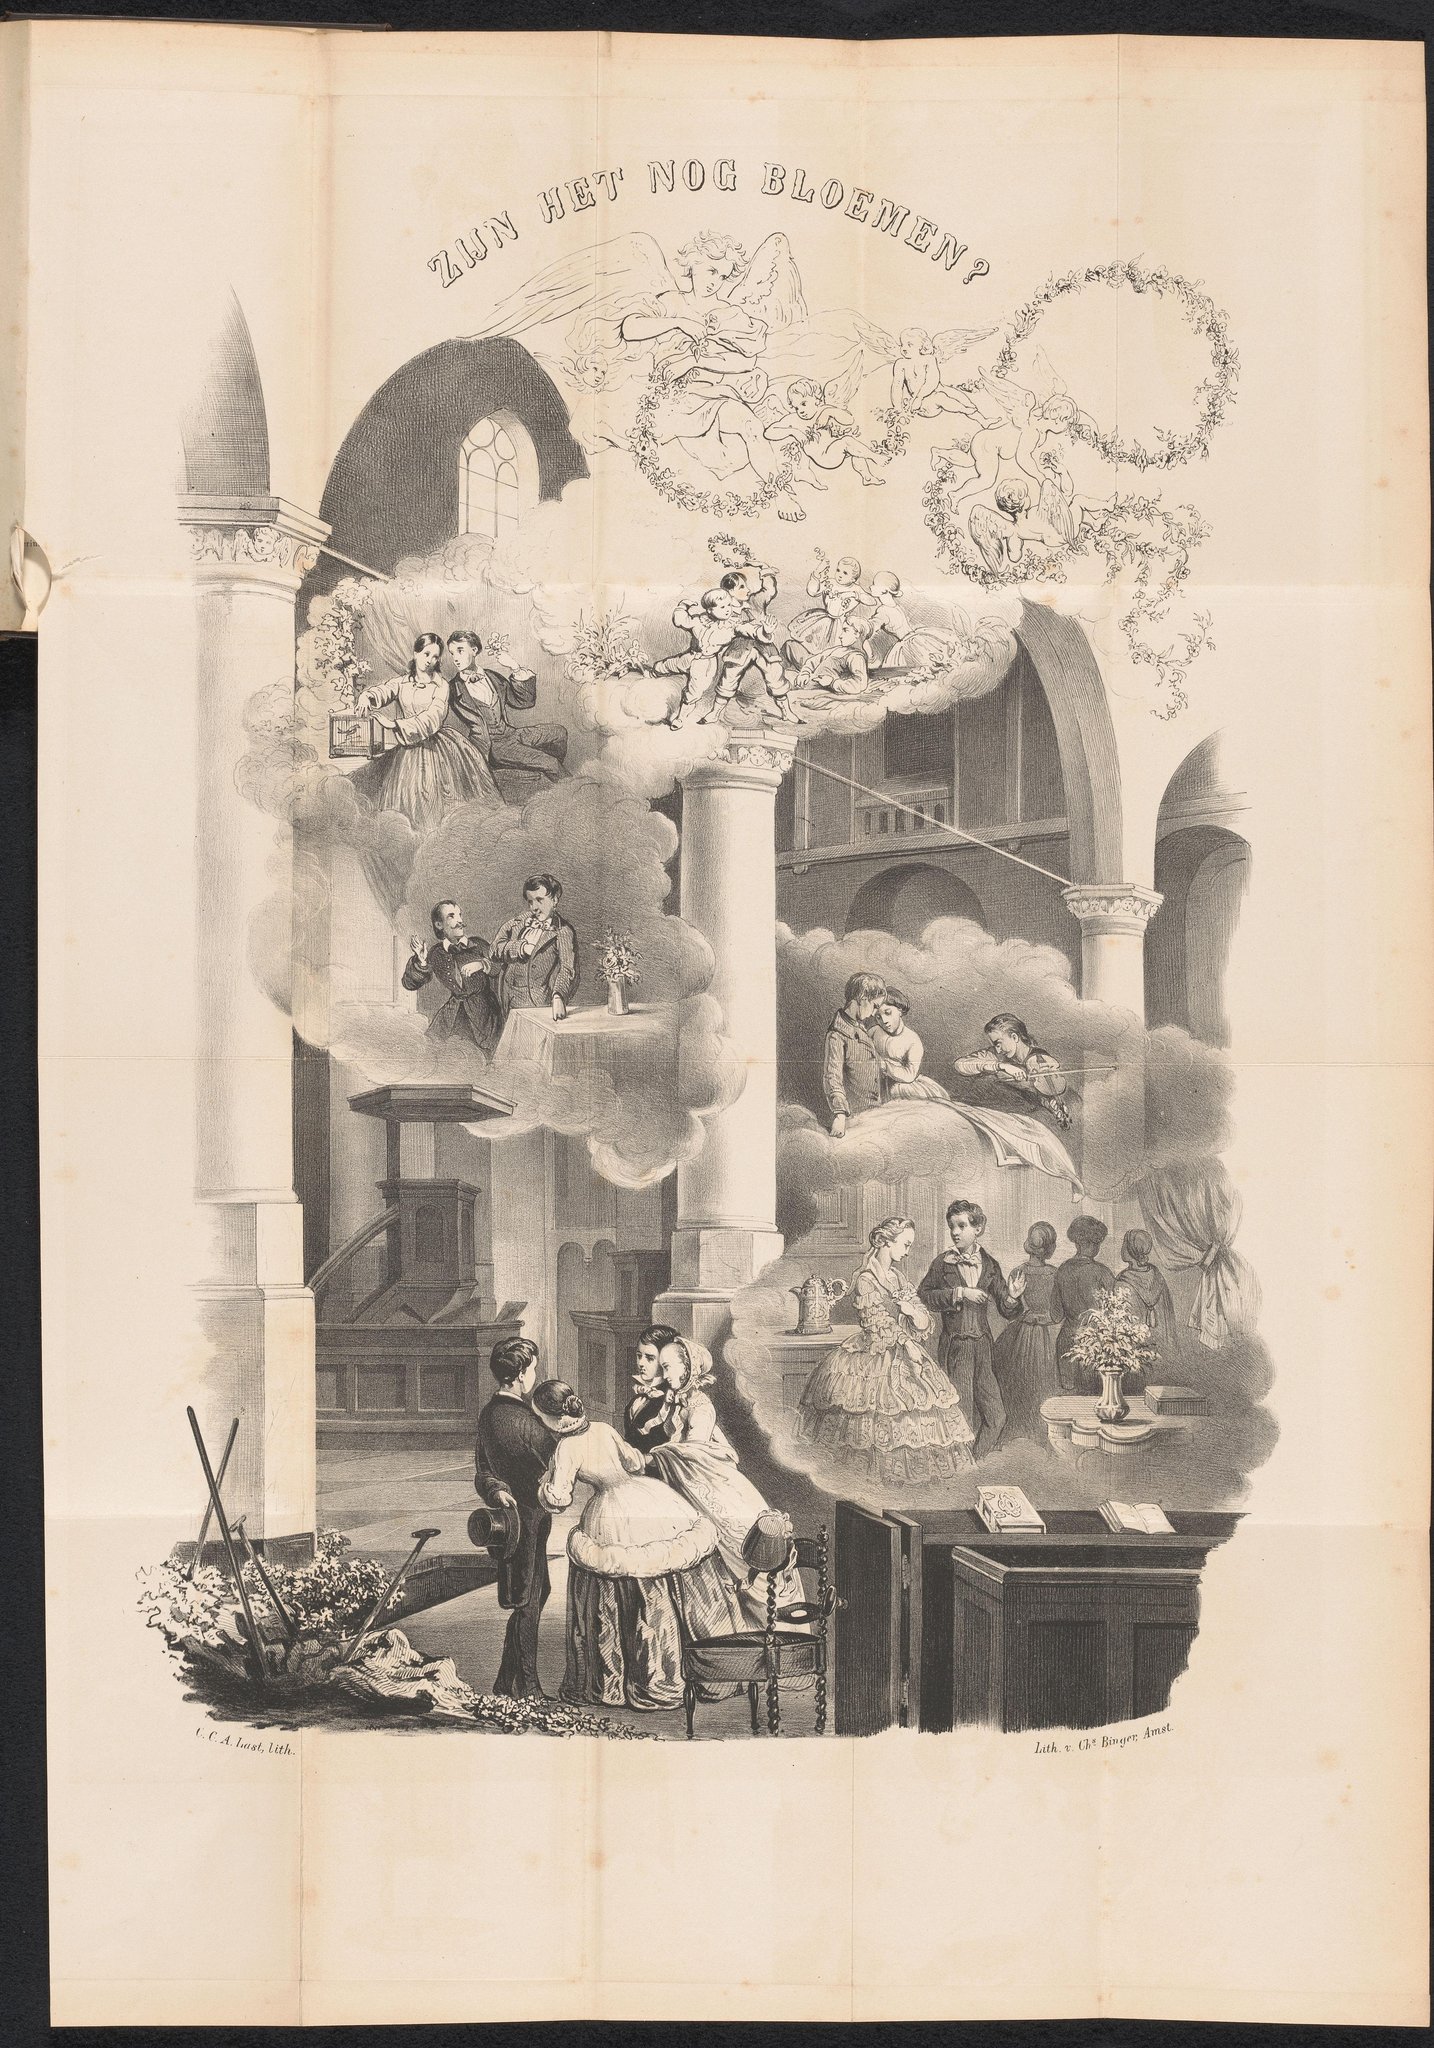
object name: print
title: Prent in Amsterdamse studentenalmanak, 1856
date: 1856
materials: paper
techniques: lithograph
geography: amsterdam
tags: student life, amsterdam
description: Kerkinterieur met allegorie op de levensloop van vier jongelieden. Allegorische plaat in de studentenalmanak van de Universiteit van Amsterdam van het jaar 1856.